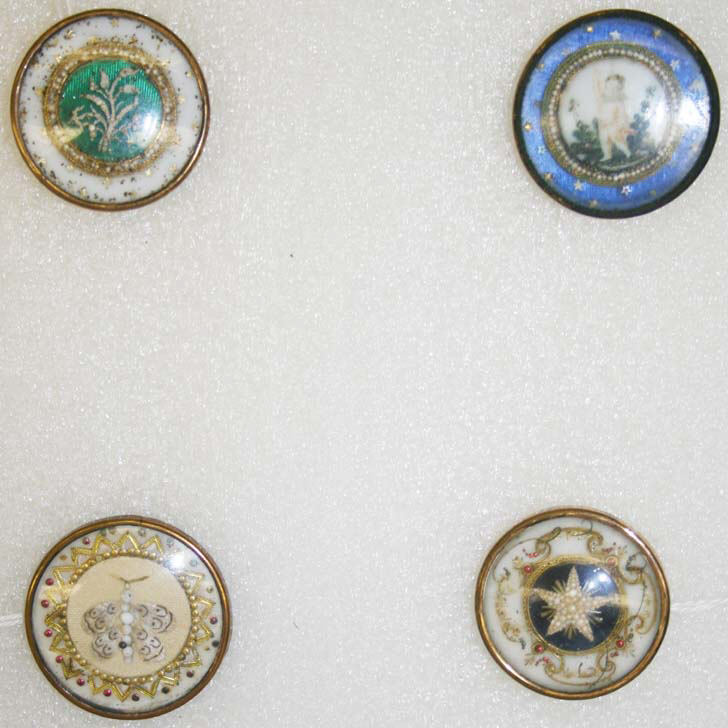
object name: button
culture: french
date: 1775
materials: glass, metal, pearl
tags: cupid,butterflies,stars